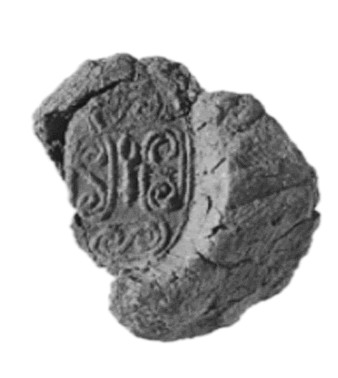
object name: sealing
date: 2030-1640 BCE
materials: clay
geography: egypt